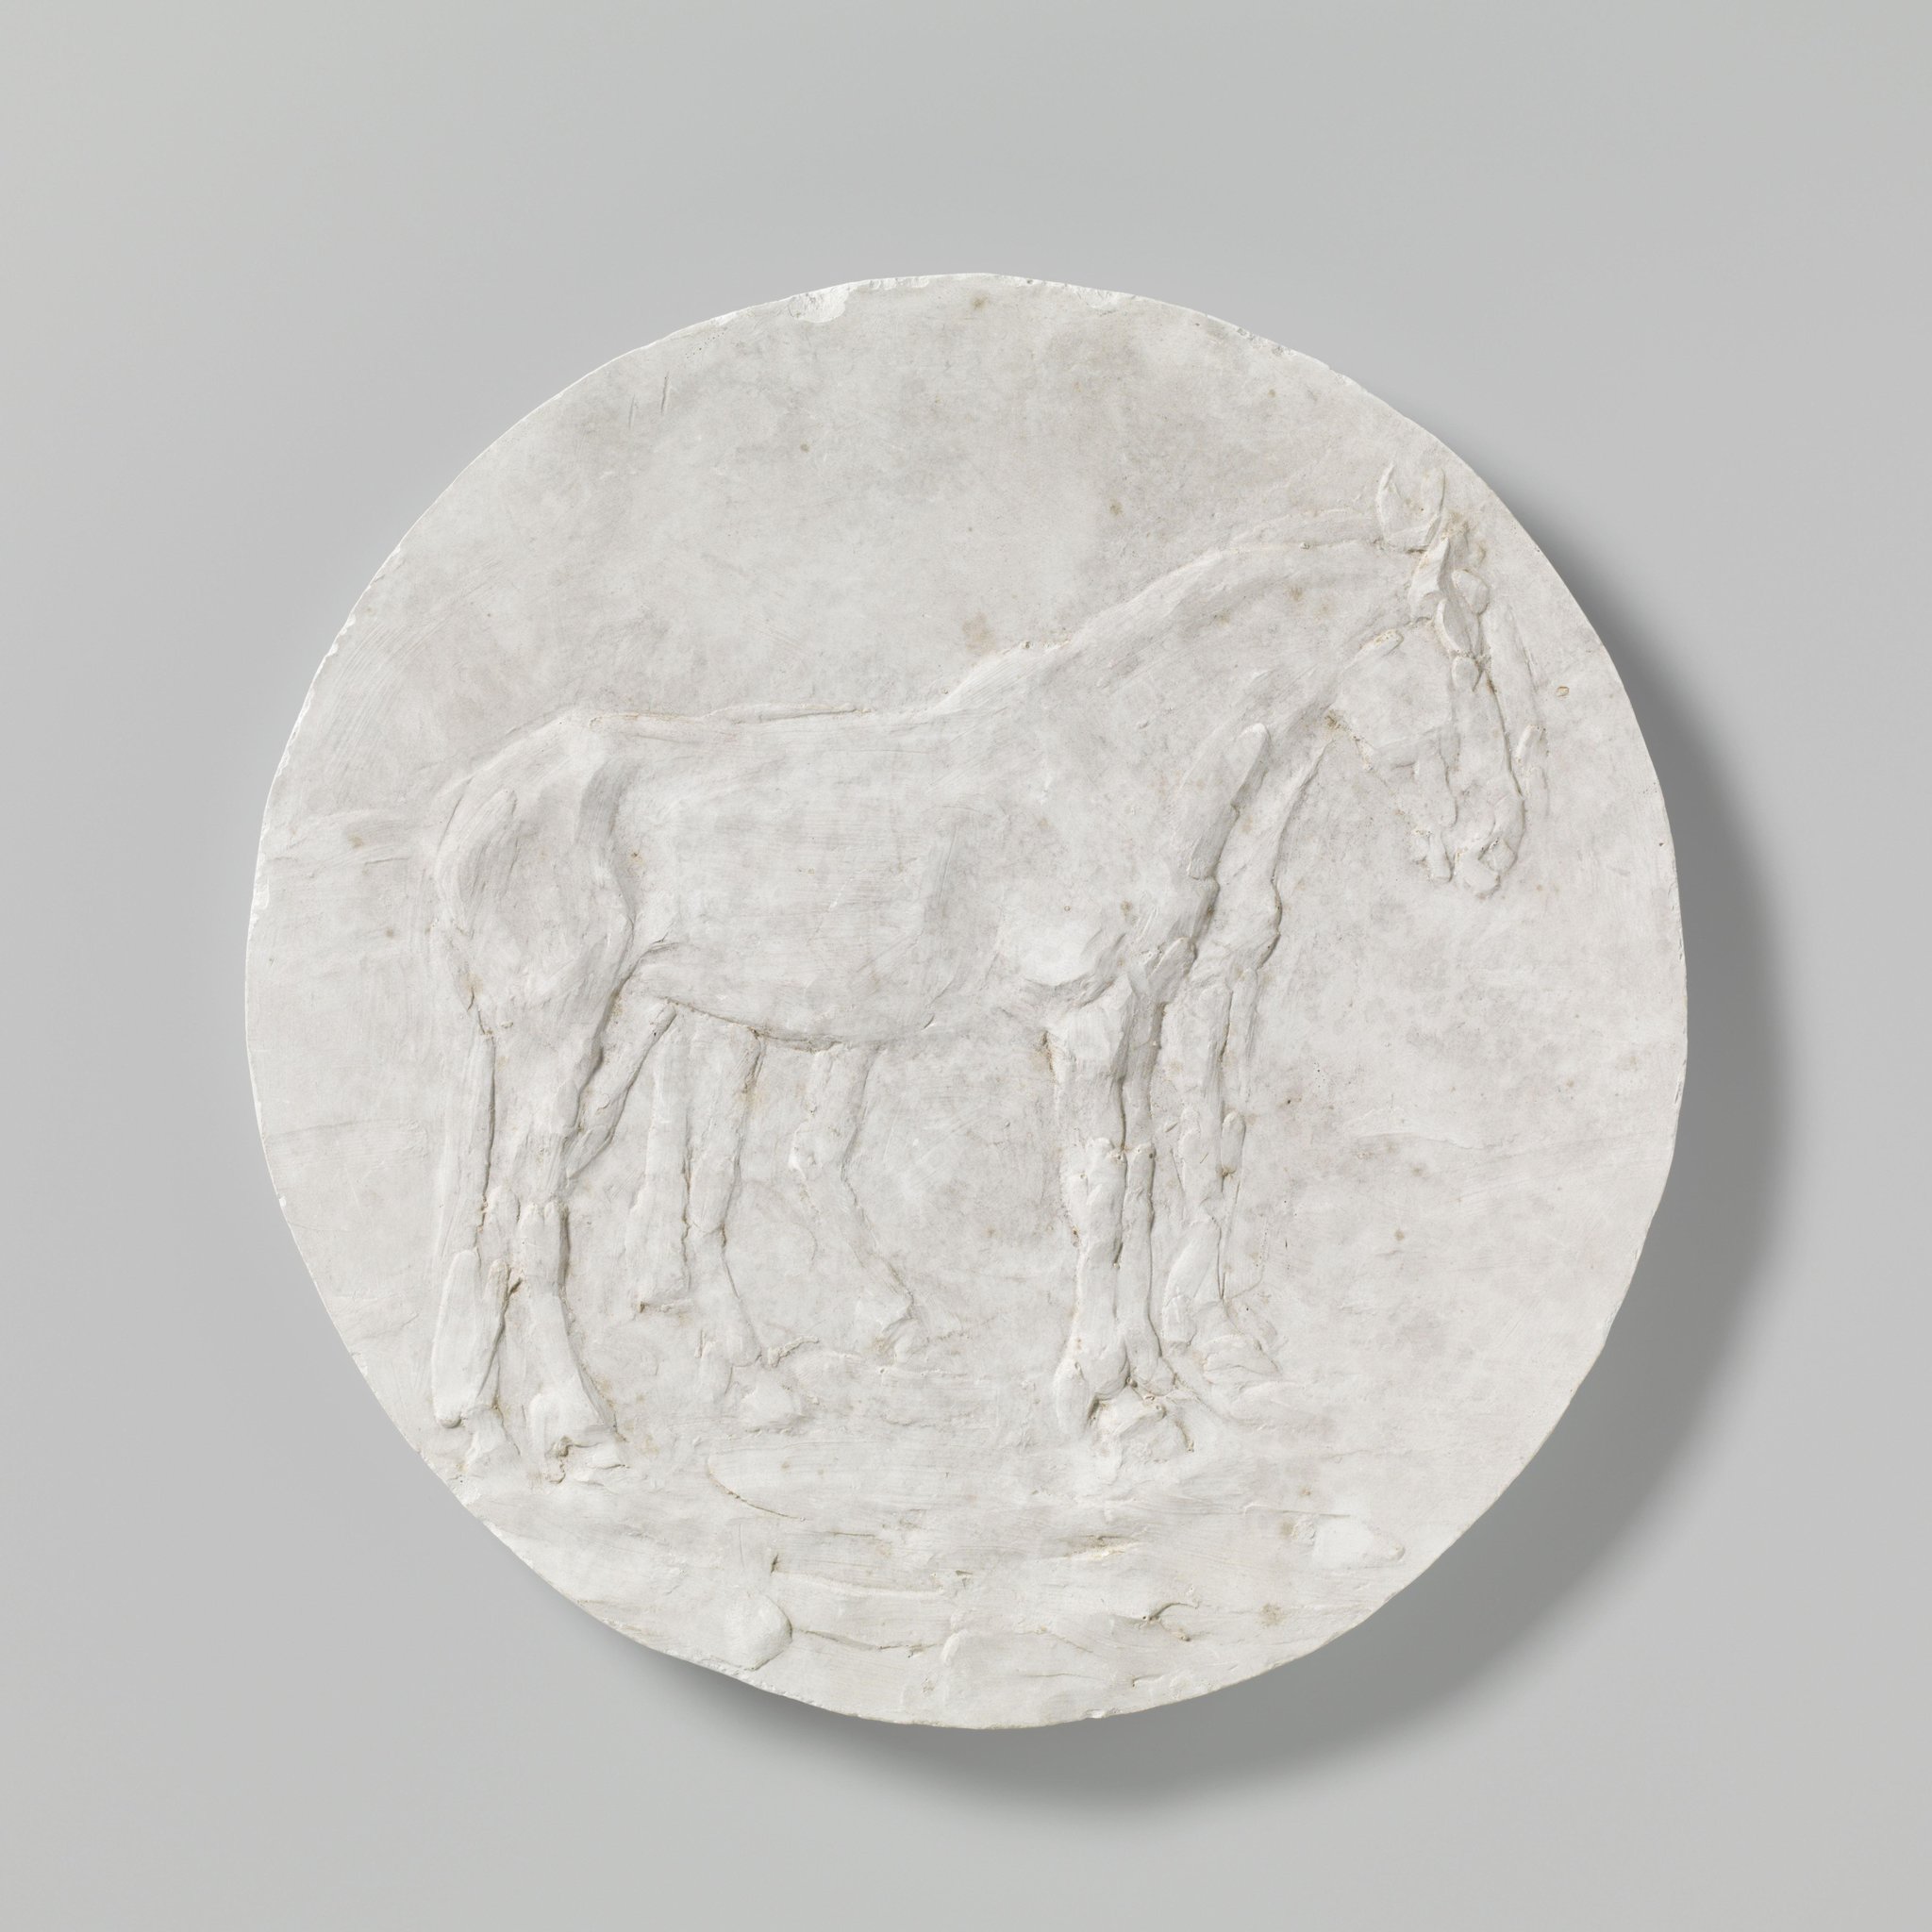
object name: design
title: Reliëf van gips met twee paarden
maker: lambertus zijl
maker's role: designer, draughtsman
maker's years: 1866-1947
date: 1876-1947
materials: gypsum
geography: netherlands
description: Reliëf, rond, van gips met voorstelling van twee paarden. Vermoedelijk ontwerp voor een penning